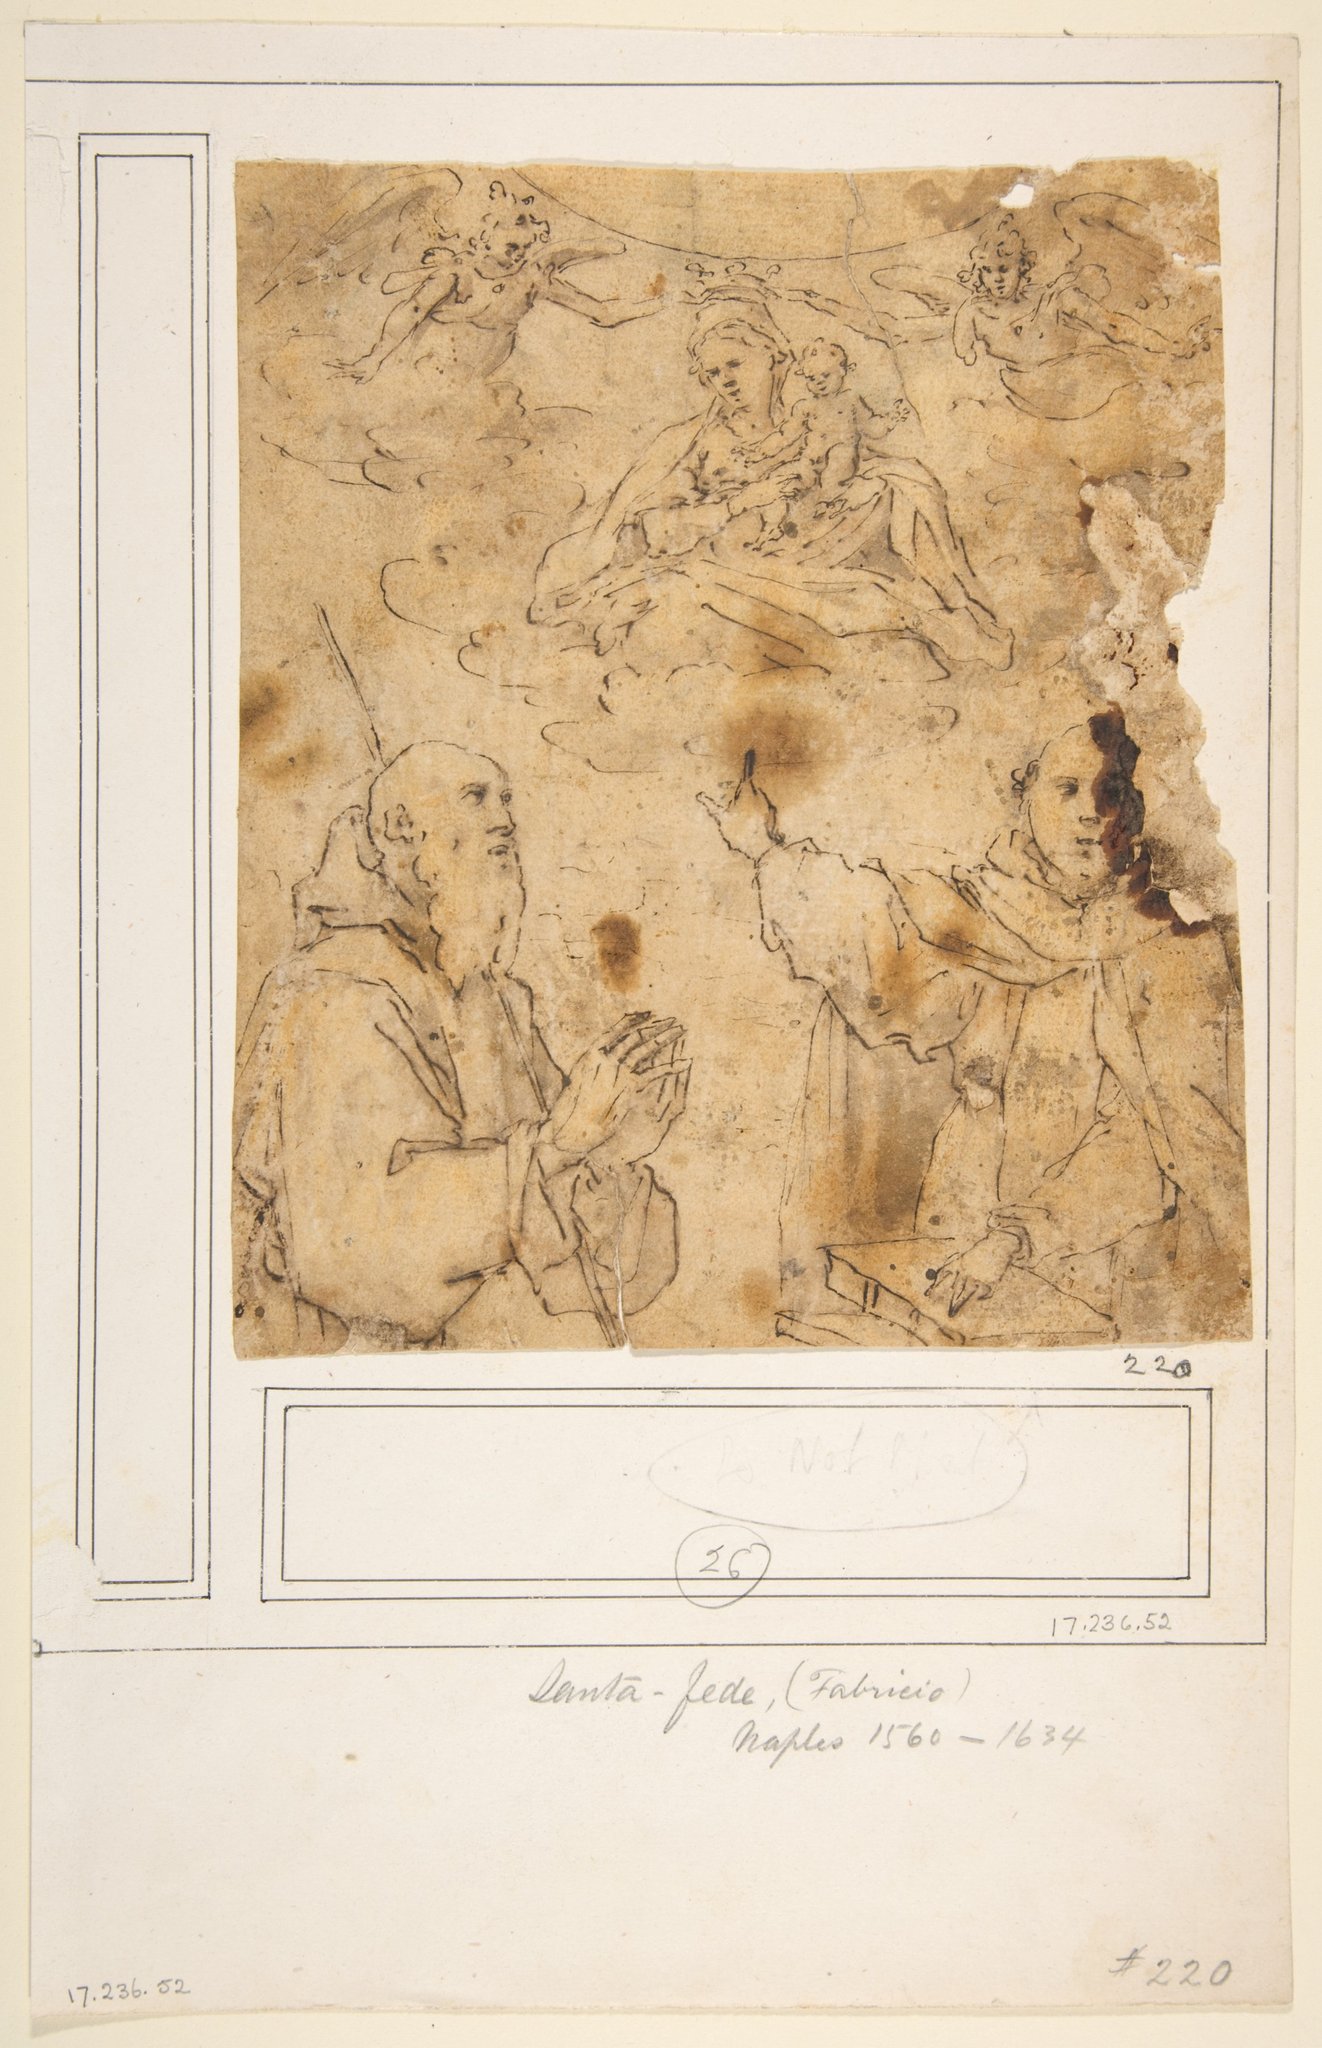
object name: drawing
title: Virgin and Child with two angels appearing to two saints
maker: fabrizio santafede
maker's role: artist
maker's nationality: italian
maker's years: 1576-1623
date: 1575-1623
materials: ink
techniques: pen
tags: angels,madonna and child,saints